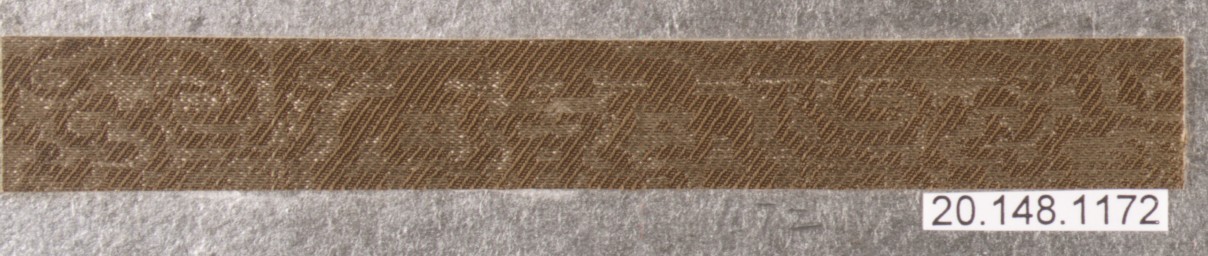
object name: piece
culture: japanese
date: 1801-1900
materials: silk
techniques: compound weave